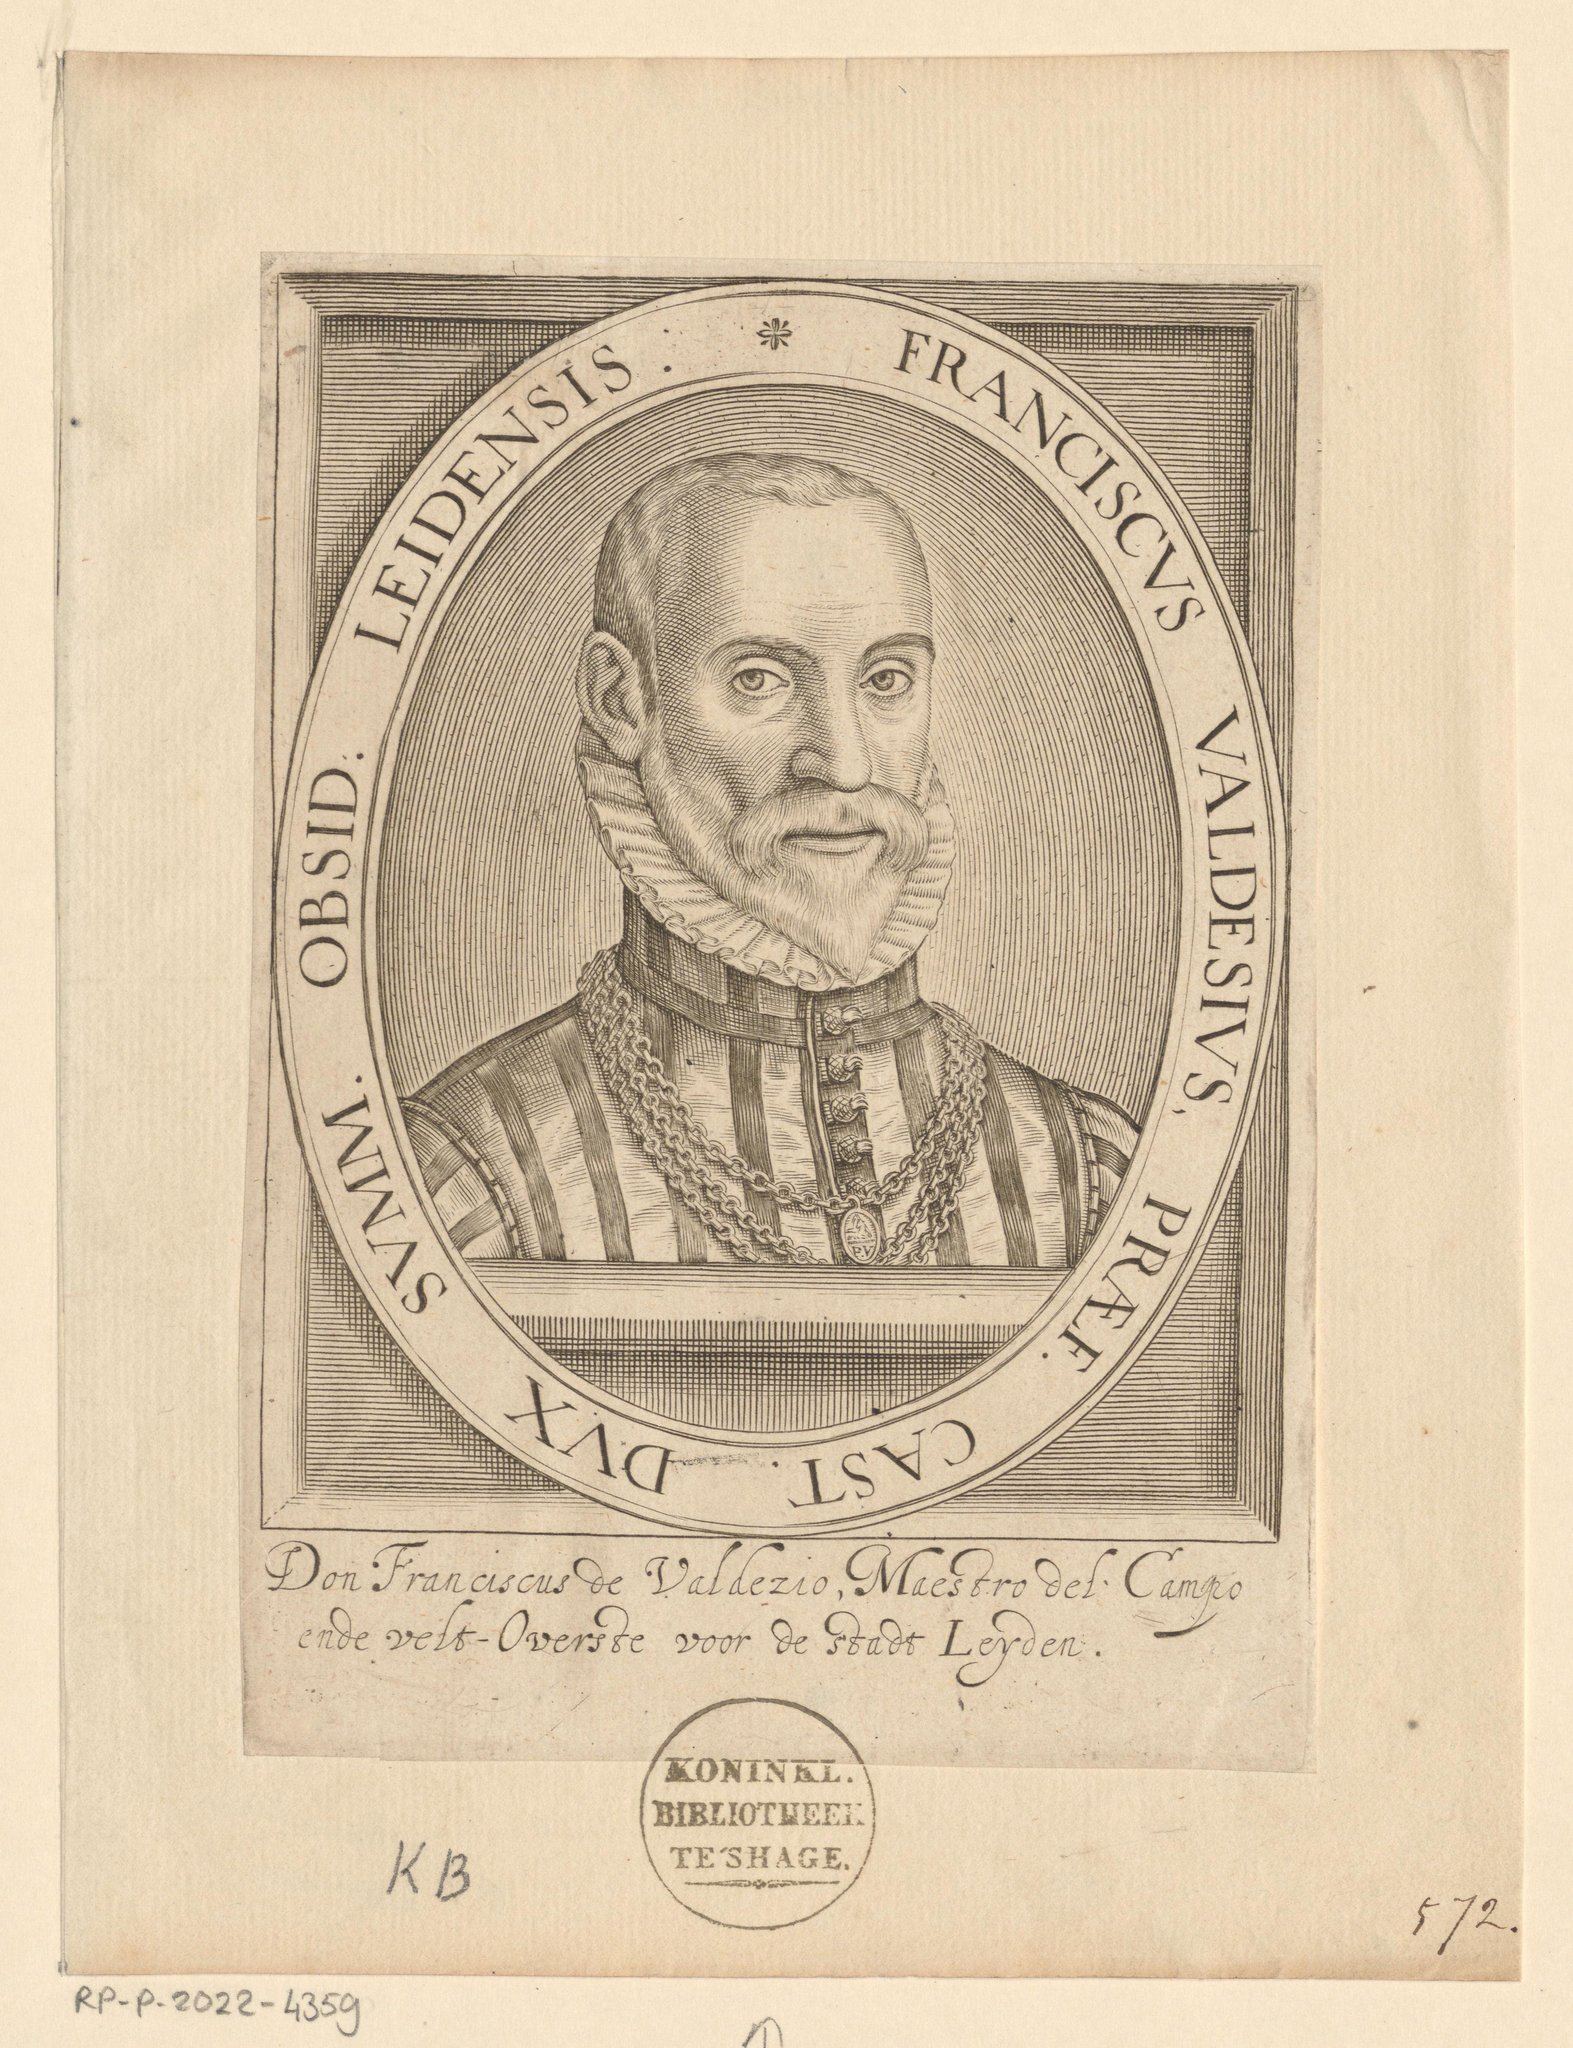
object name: print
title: Portret van Francisco de Valdez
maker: Anonymous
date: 1614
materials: paper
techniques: engraving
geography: northern netherlands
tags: commander-in-chief, general, marshal, historical persons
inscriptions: collector's mark: ‘KONINKL. BIBLIOTHEEK TE'SHAGE.’, number: ‘572’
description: Prent waarschijnlijk uit: Meteren, Emanuel van. Historie der Nederlandscher ende haerder na-buren oorlogen ende geschiedenissen (...). Den Haag: Hillebrant Iacobsz. van Wouw, 1614. Of uit een latere uitgave (1623, 1635).